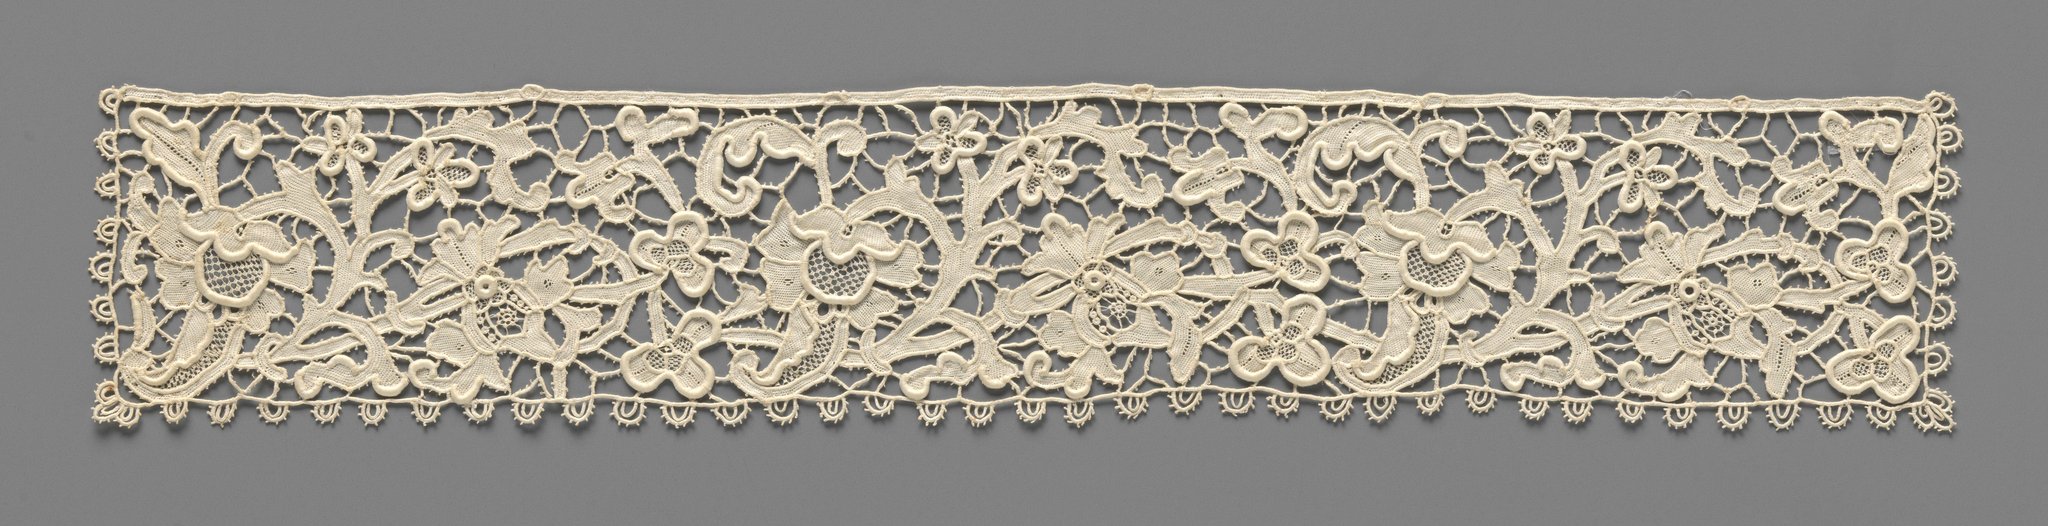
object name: cuff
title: Manchet van naaldkant met getongde bloem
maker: Anonymous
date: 1885-1899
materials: linen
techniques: embroidery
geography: belgium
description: Manchet van naturelkleurige naaldkant: Venetiaanse reliëfkant. Tegen een open spijlengrond staat een lopend patroon van ranken met granaatappels en een getongde bloem. Langs drie zijden een lijst met verdubbelde boogjes.